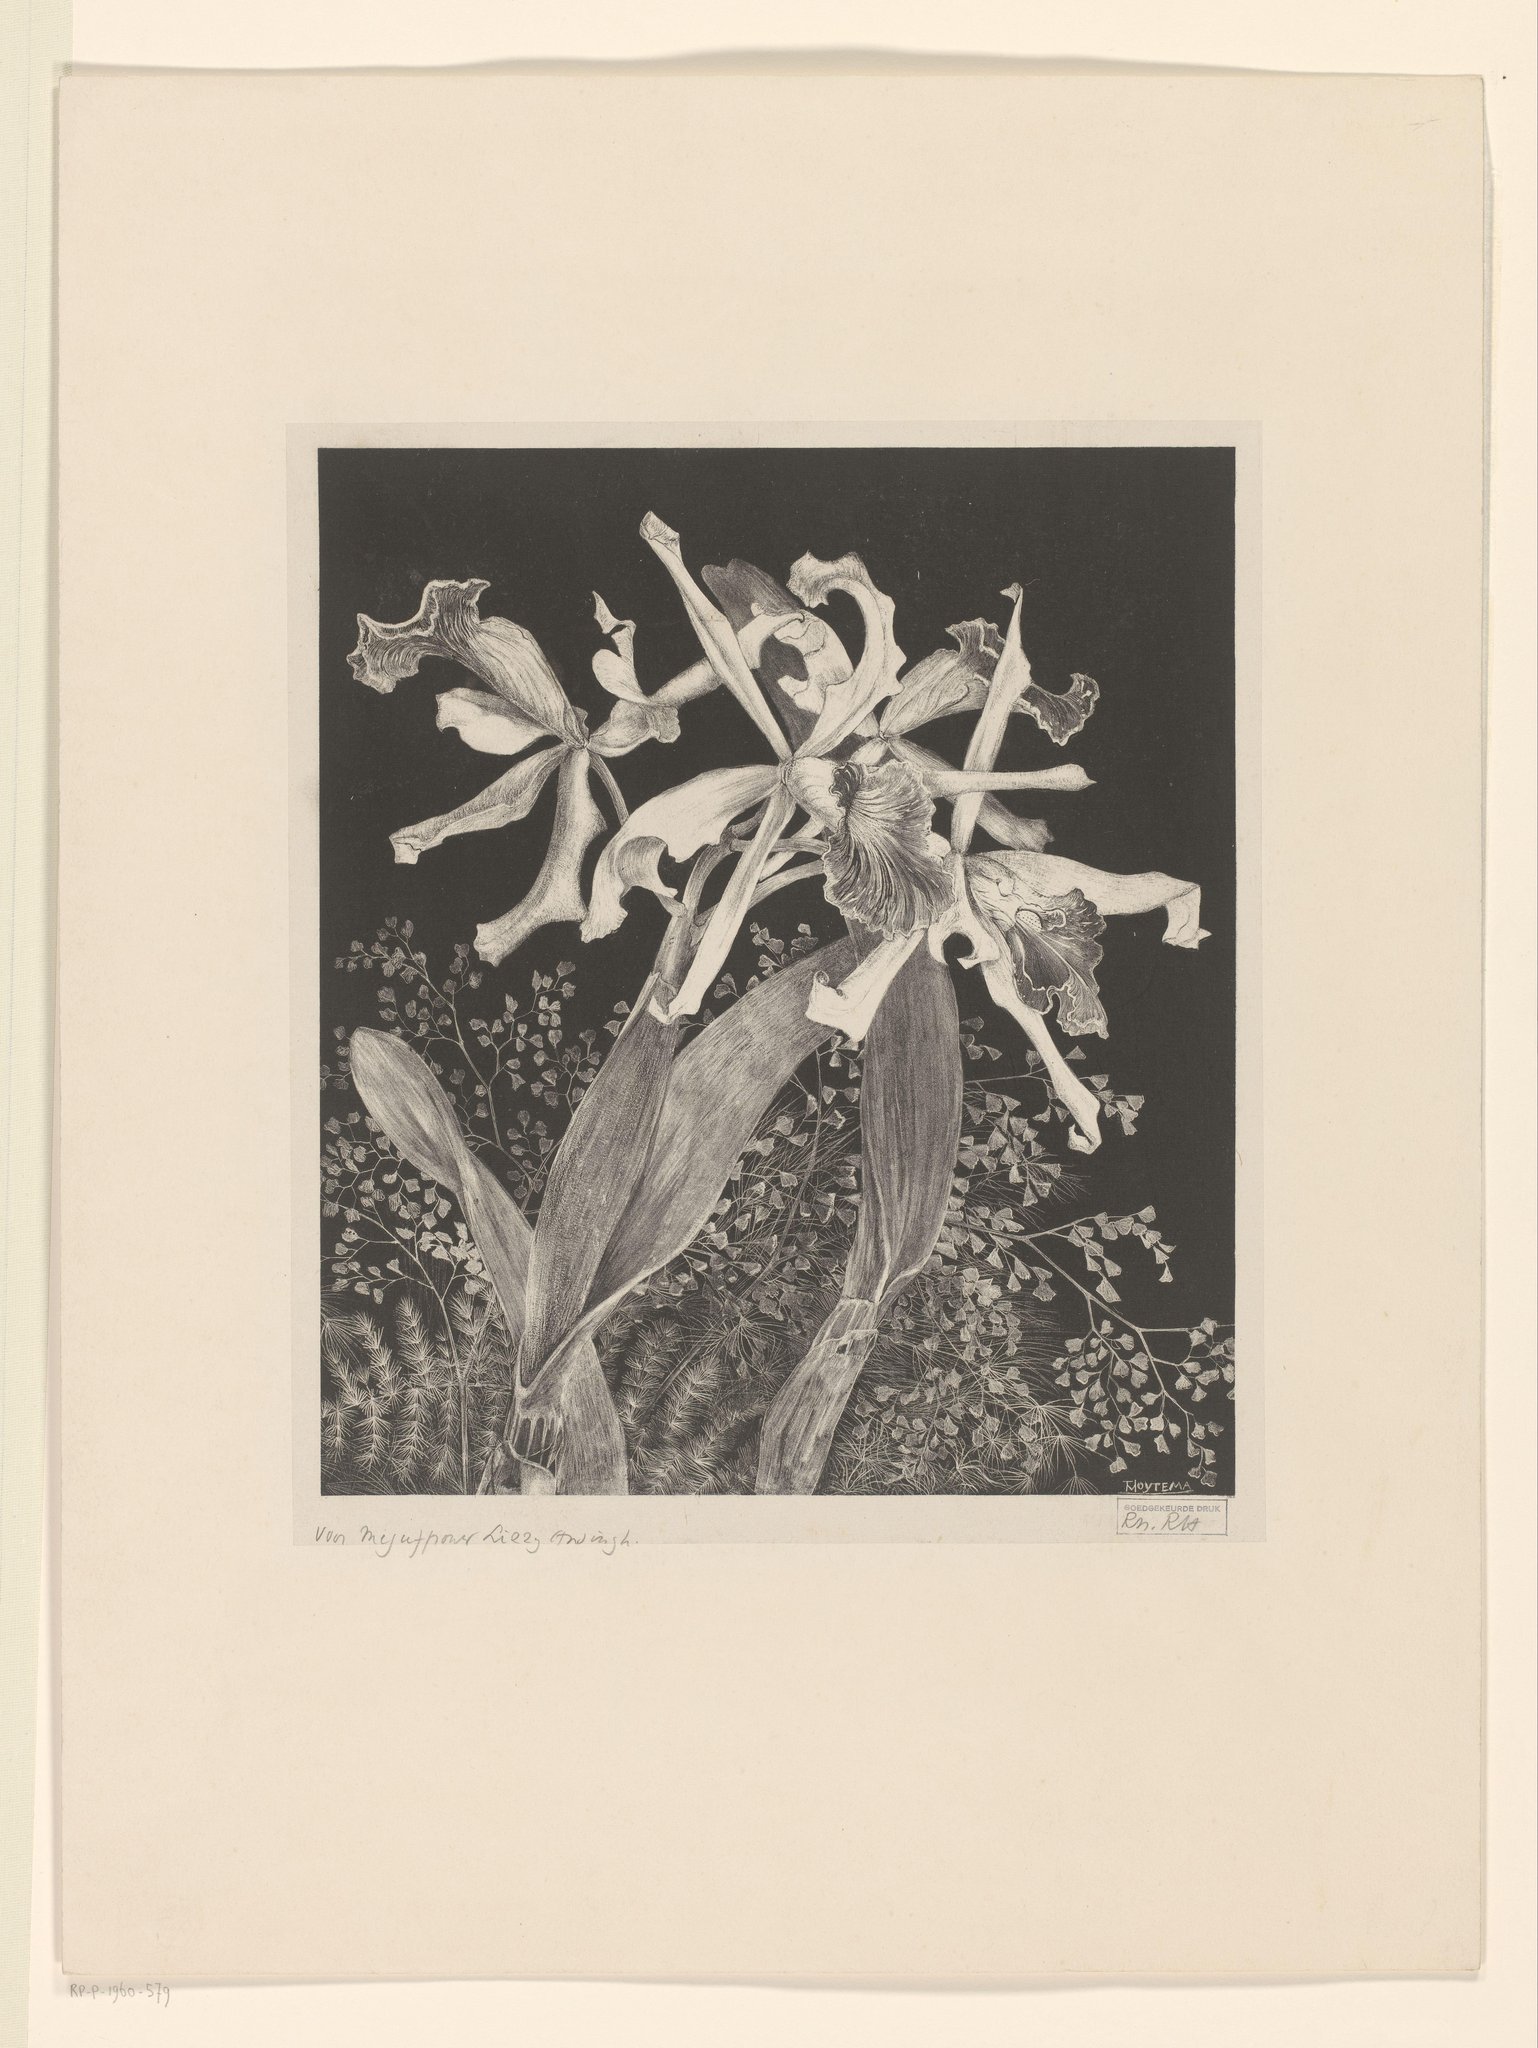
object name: print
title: Bloemstudies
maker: theo van hoytema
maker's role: draughtsman, painter, print maker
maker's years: 1863-1917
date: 1900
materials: paper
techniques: lithograph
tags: flowers: orchid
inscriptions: stamp: ‘Goedgekeurde druk Rn. RH’, collector's mark: Lugt 2228, dedication: ‘voor mejuffrouw Lizzy Ansingh’